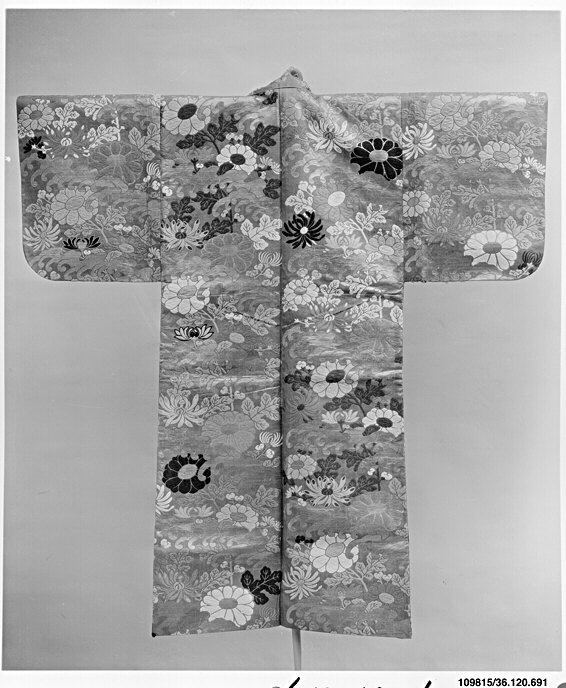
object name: noh robe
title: Noh Robe (Karaori) with Chrysanthemums and Waves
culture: japanese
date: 1801-1850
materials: metal thread, silk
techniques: brocade, weave